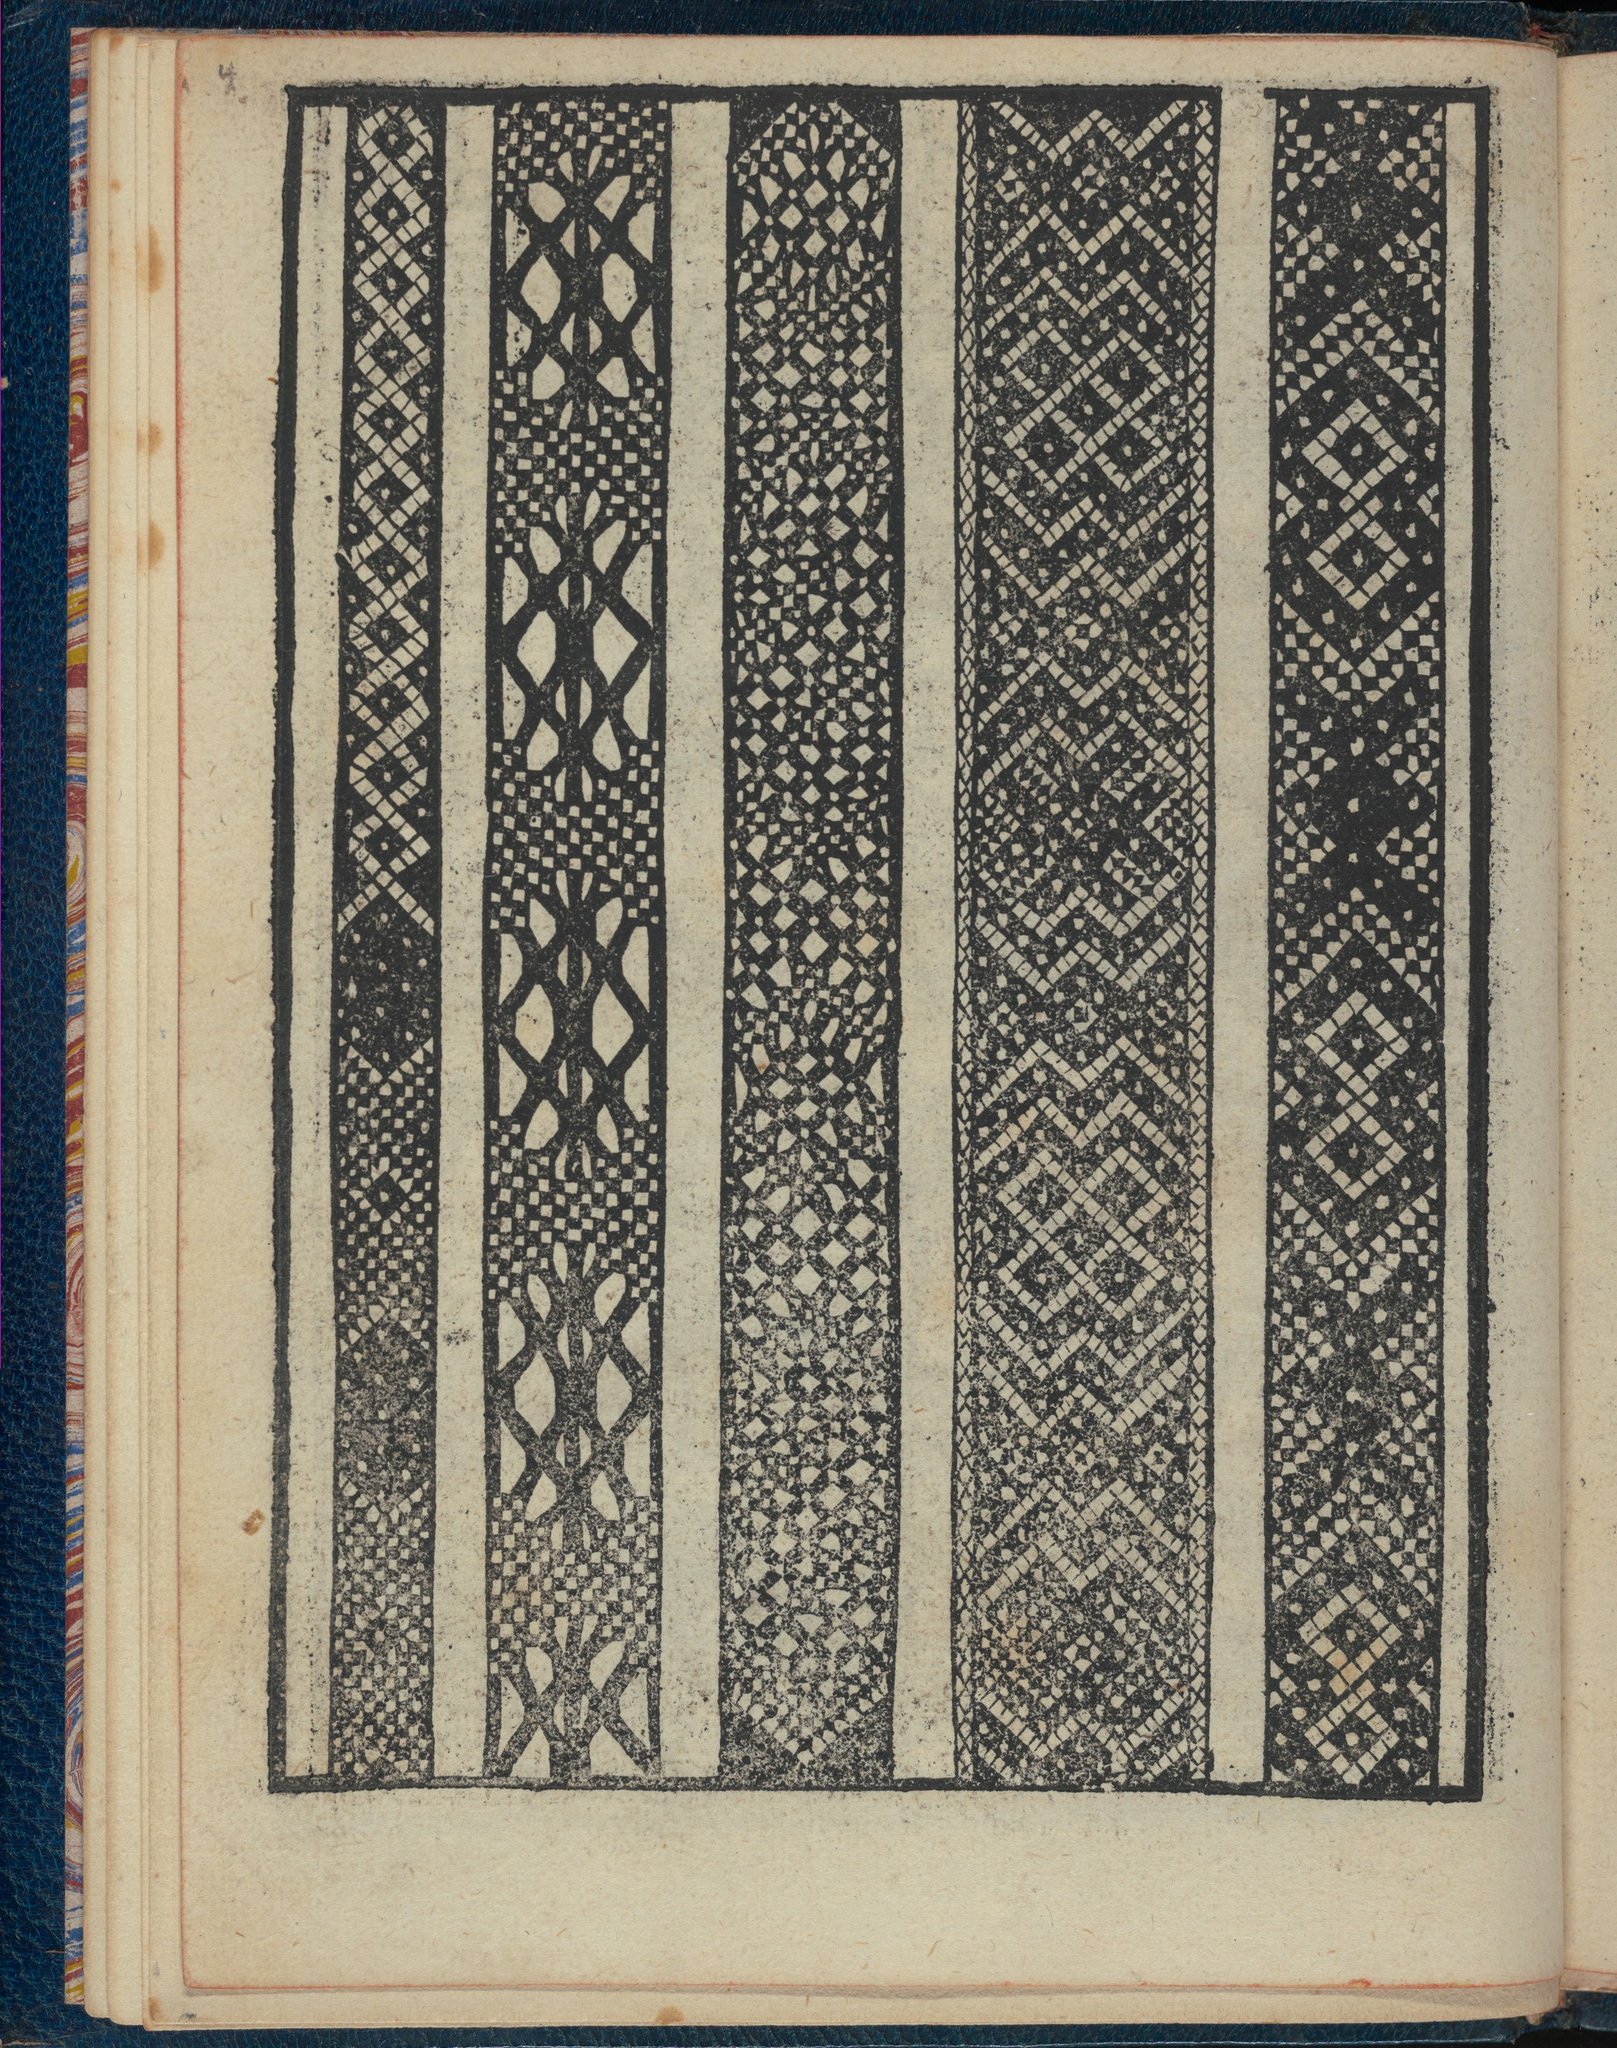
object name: book print ornament architecture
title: Le Pompe: Opera Nova, page 2 (verso)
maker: giovanni battista & marchio sessa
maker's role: publisher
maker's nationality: italian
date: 1557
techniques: woodcut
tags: ornament